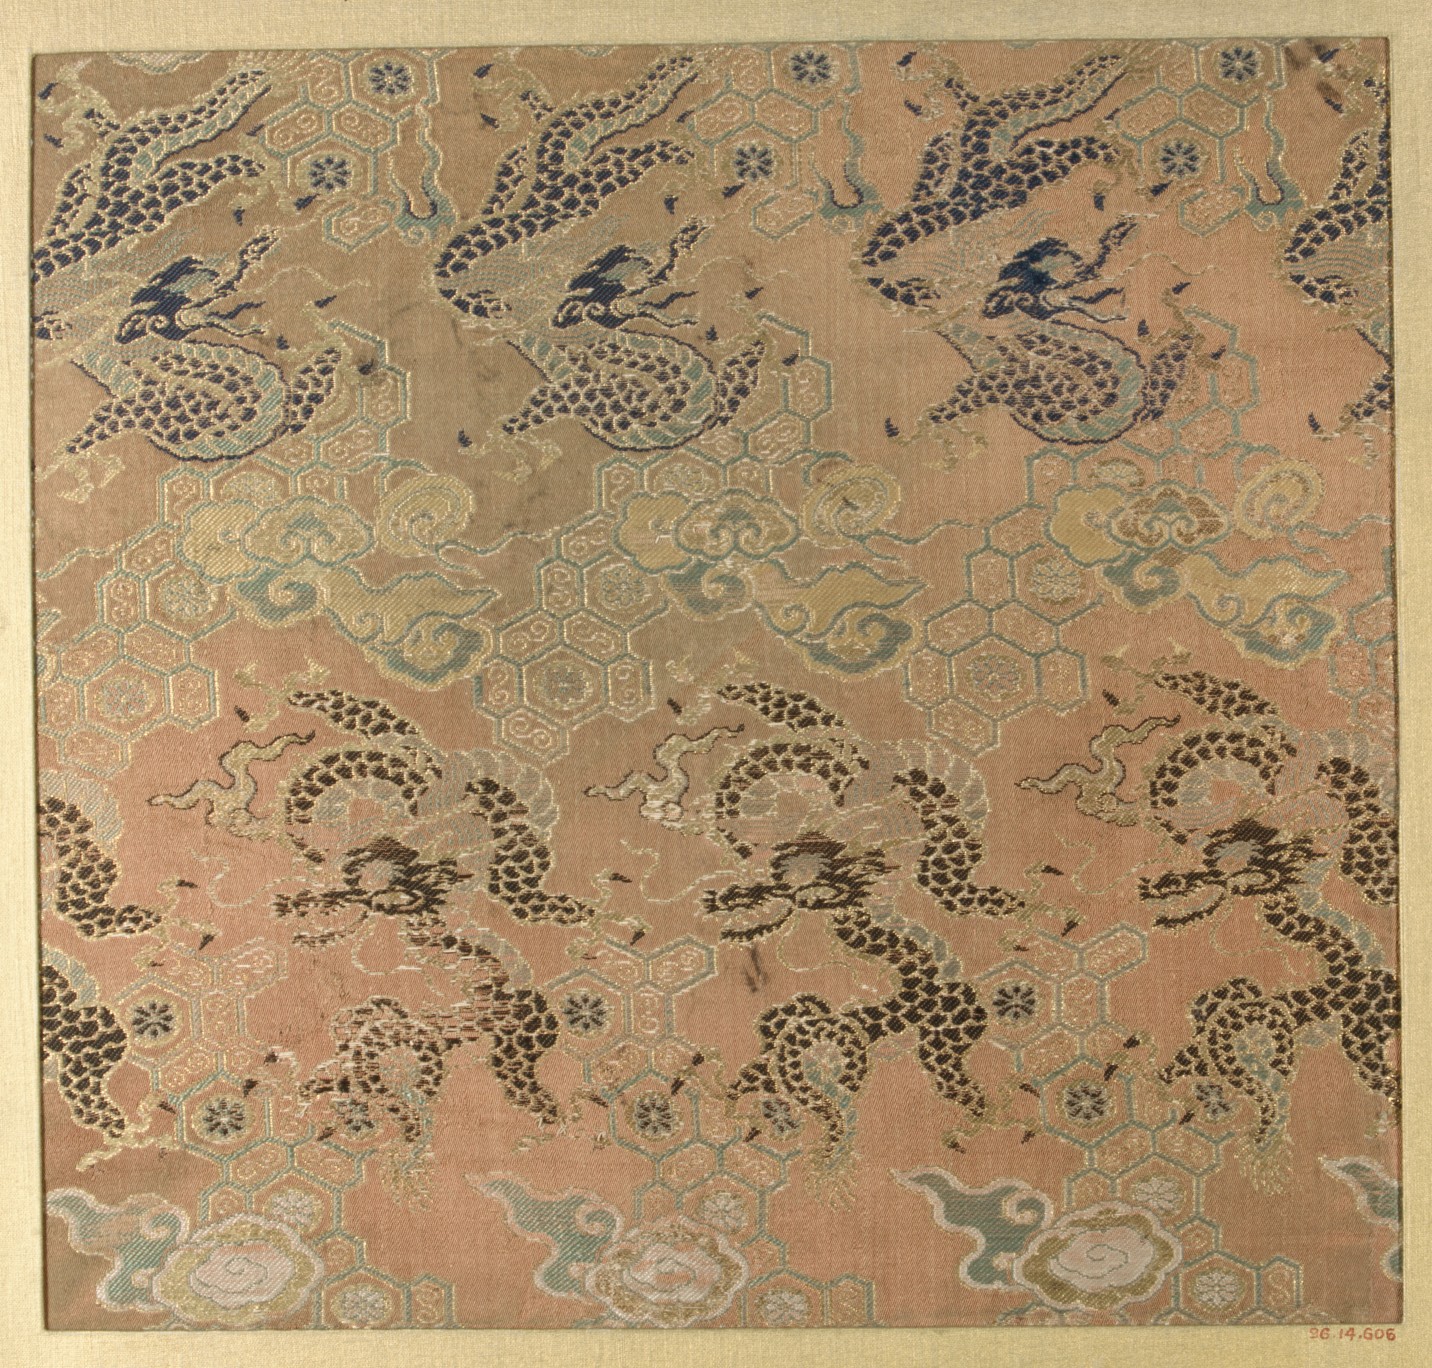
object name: piece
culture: japanese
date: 1701-1900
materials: silk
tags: dragons